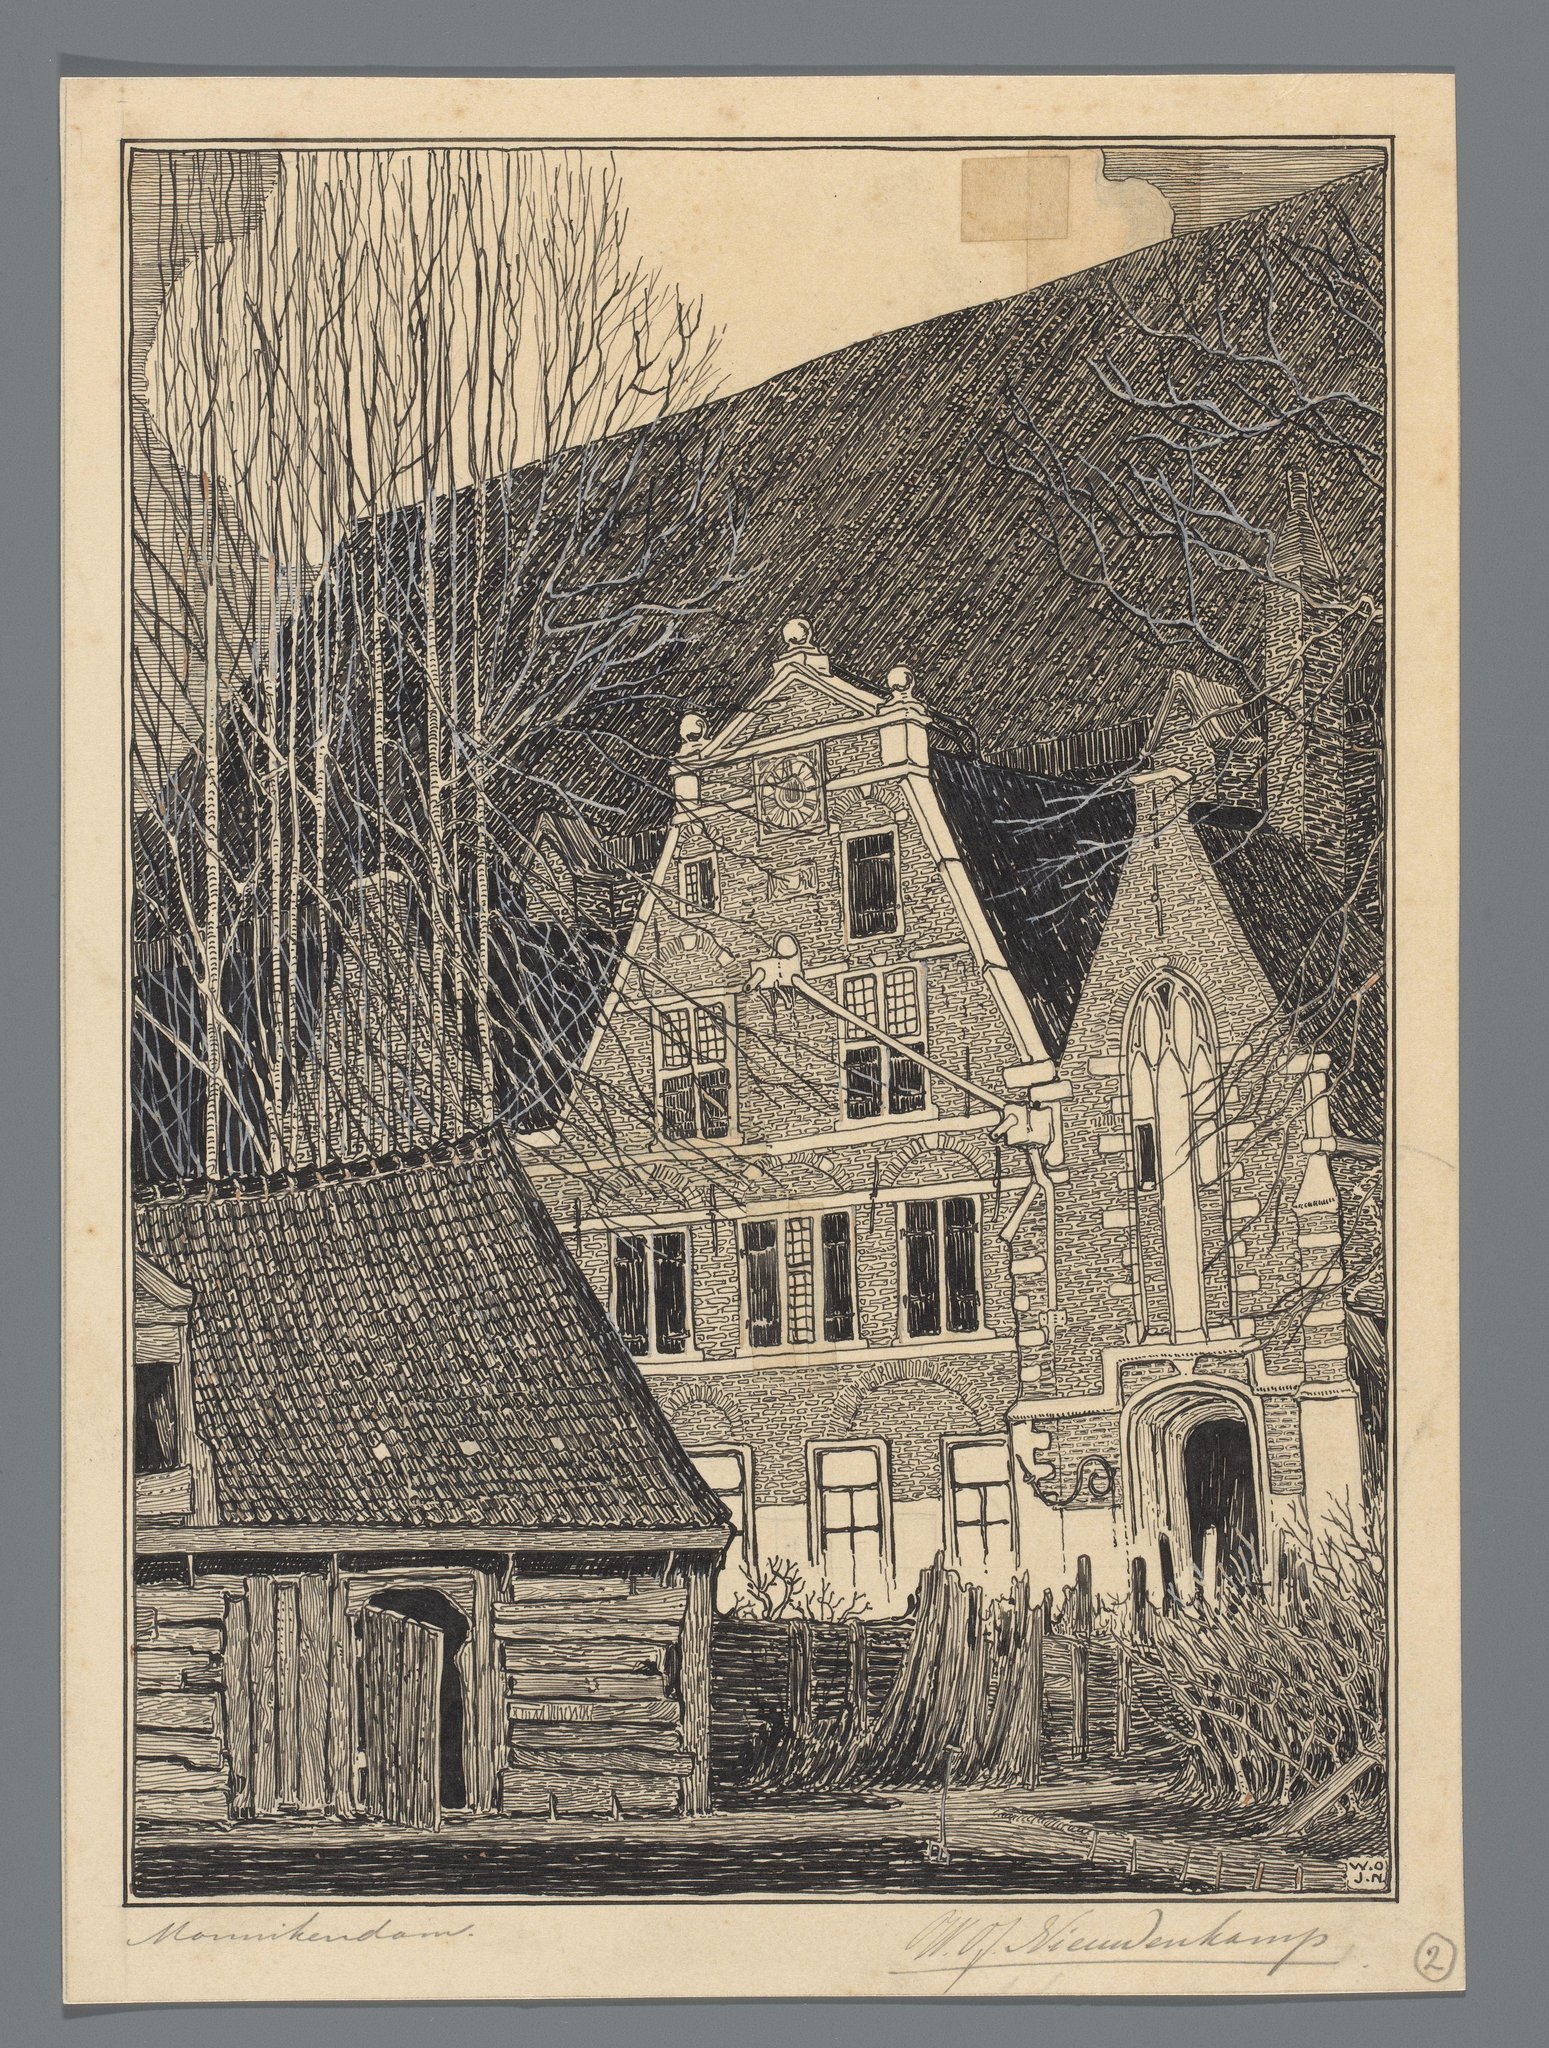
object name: drawing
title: Noordzijde van de Grote of Sint-Nicolaaskerk te Monnickendam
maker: wijnand otto jan nieuwenkamp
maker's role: draughtsman, print maker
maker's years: 1874-1950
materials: paint, ink, paper, pencil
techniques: brush, pen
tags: church (exterior)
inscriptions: inscription: ‘Monnikendam’, annotation: ‘zijn/ gelijke grootte/ uit[...] uitvoeren’, number: ‘2’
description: Ontwerp voor een boekillustratie voor: Nieuwenkamp, W.O.J. en Veldheer, J.G. Oude Hollandsche steden aan de Zuiderzee. Haarlem: De Erven F. Bohn, 1897.